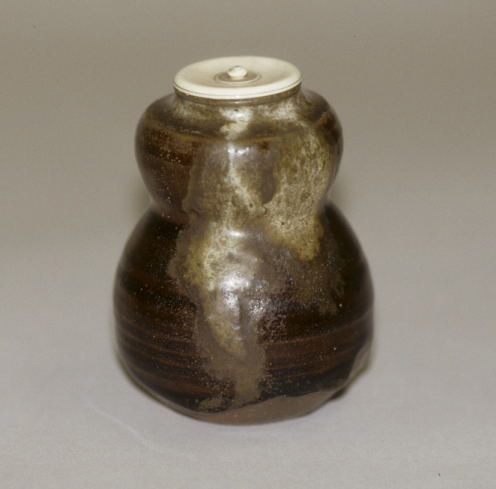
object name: tea jar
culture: japanese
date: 1500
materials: clay, glaze